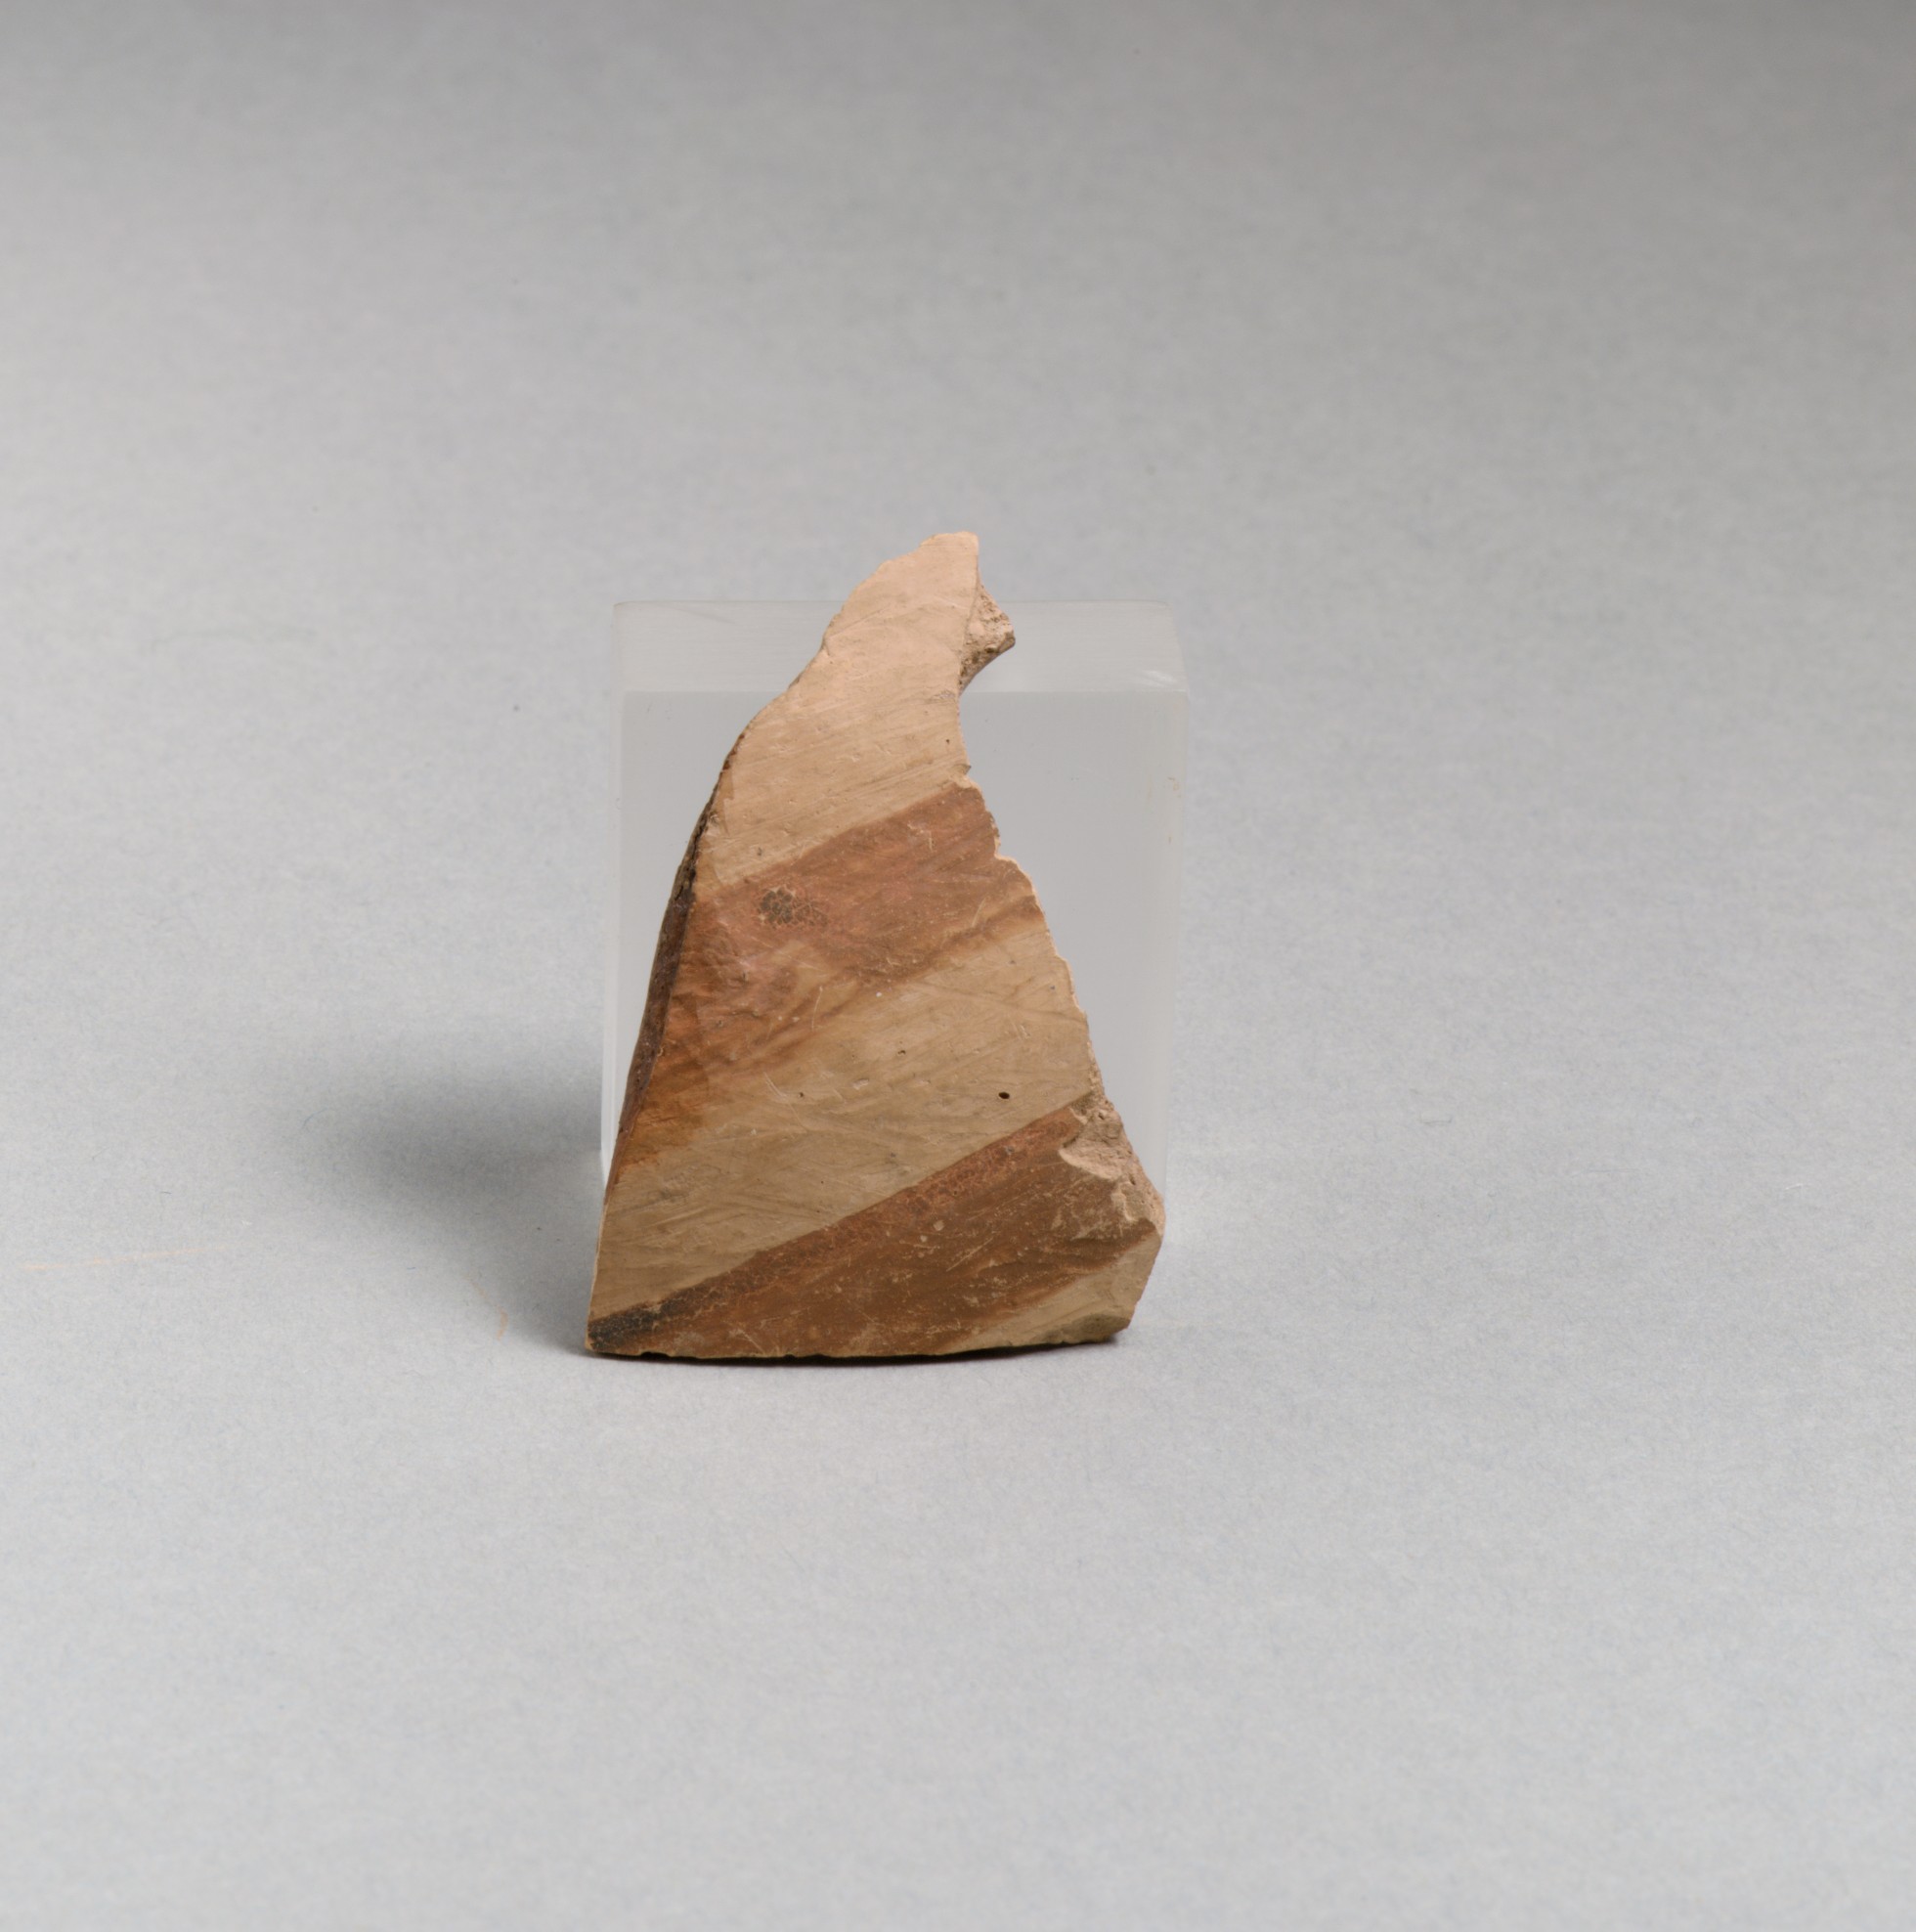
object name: vase fragment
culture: minoan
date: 1600-1450 BCE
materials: terracotta